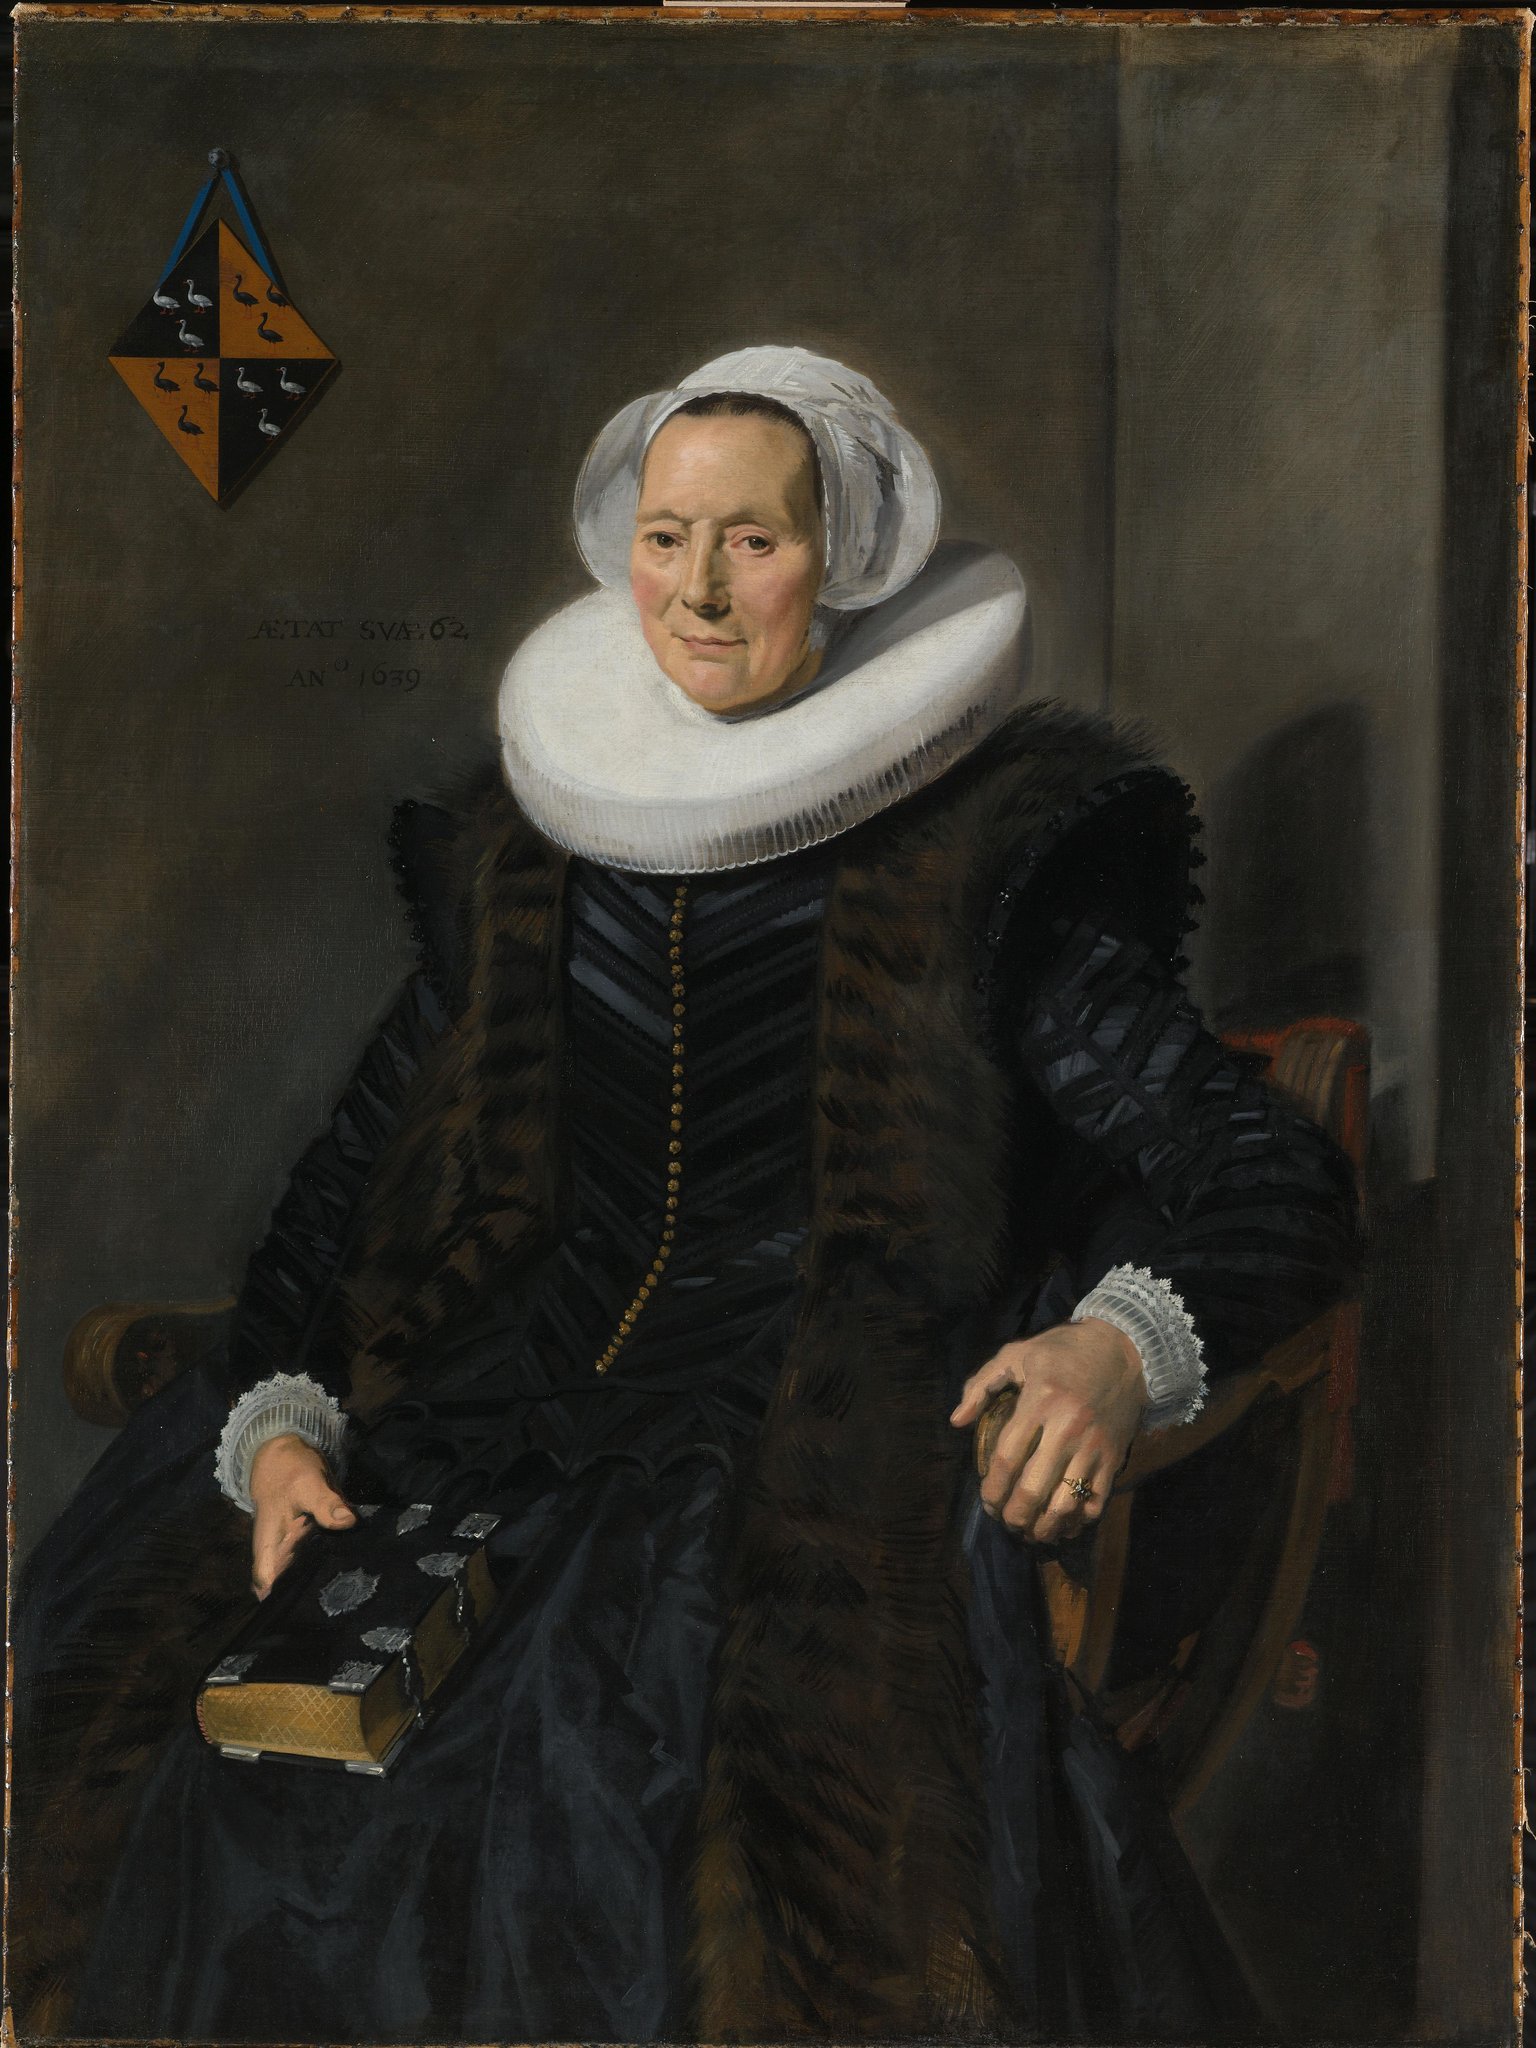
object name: painting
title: Maritge Claesdr Voogt (1577-1644), Wife of Pieter Jacobsz Olycan, Burgomaster of Haarlem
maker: frans hals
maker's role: draughtsman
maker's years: 1582-1666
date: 1639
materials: canvas, oil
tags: historical persons - bb - woman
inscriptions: coat of arms, upper left (covered with reversible paint): quartered, 1 and 4, three silver ducks with red beaks and feet on a black field; 2 and 3, three black herons with red beaks and feet on a red field, inscription and date, upper left: ‘ÆTAT: SVA. 62 / ANº 1639’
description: Maritge Vooght grew up in a Haarlem family business of brewers. She married Pieter Olycan at the age of 18. Their union allowed him to hold high positions and he became co-heir to the brewery. In addition, they established a brewery of their own, which as was usual then, was registered under Pieter’s name. Their daughter Geertruyt successfully carried on the family business. That they were prosperous is evidenced by Vooght’s expensive clothing and precious church book.